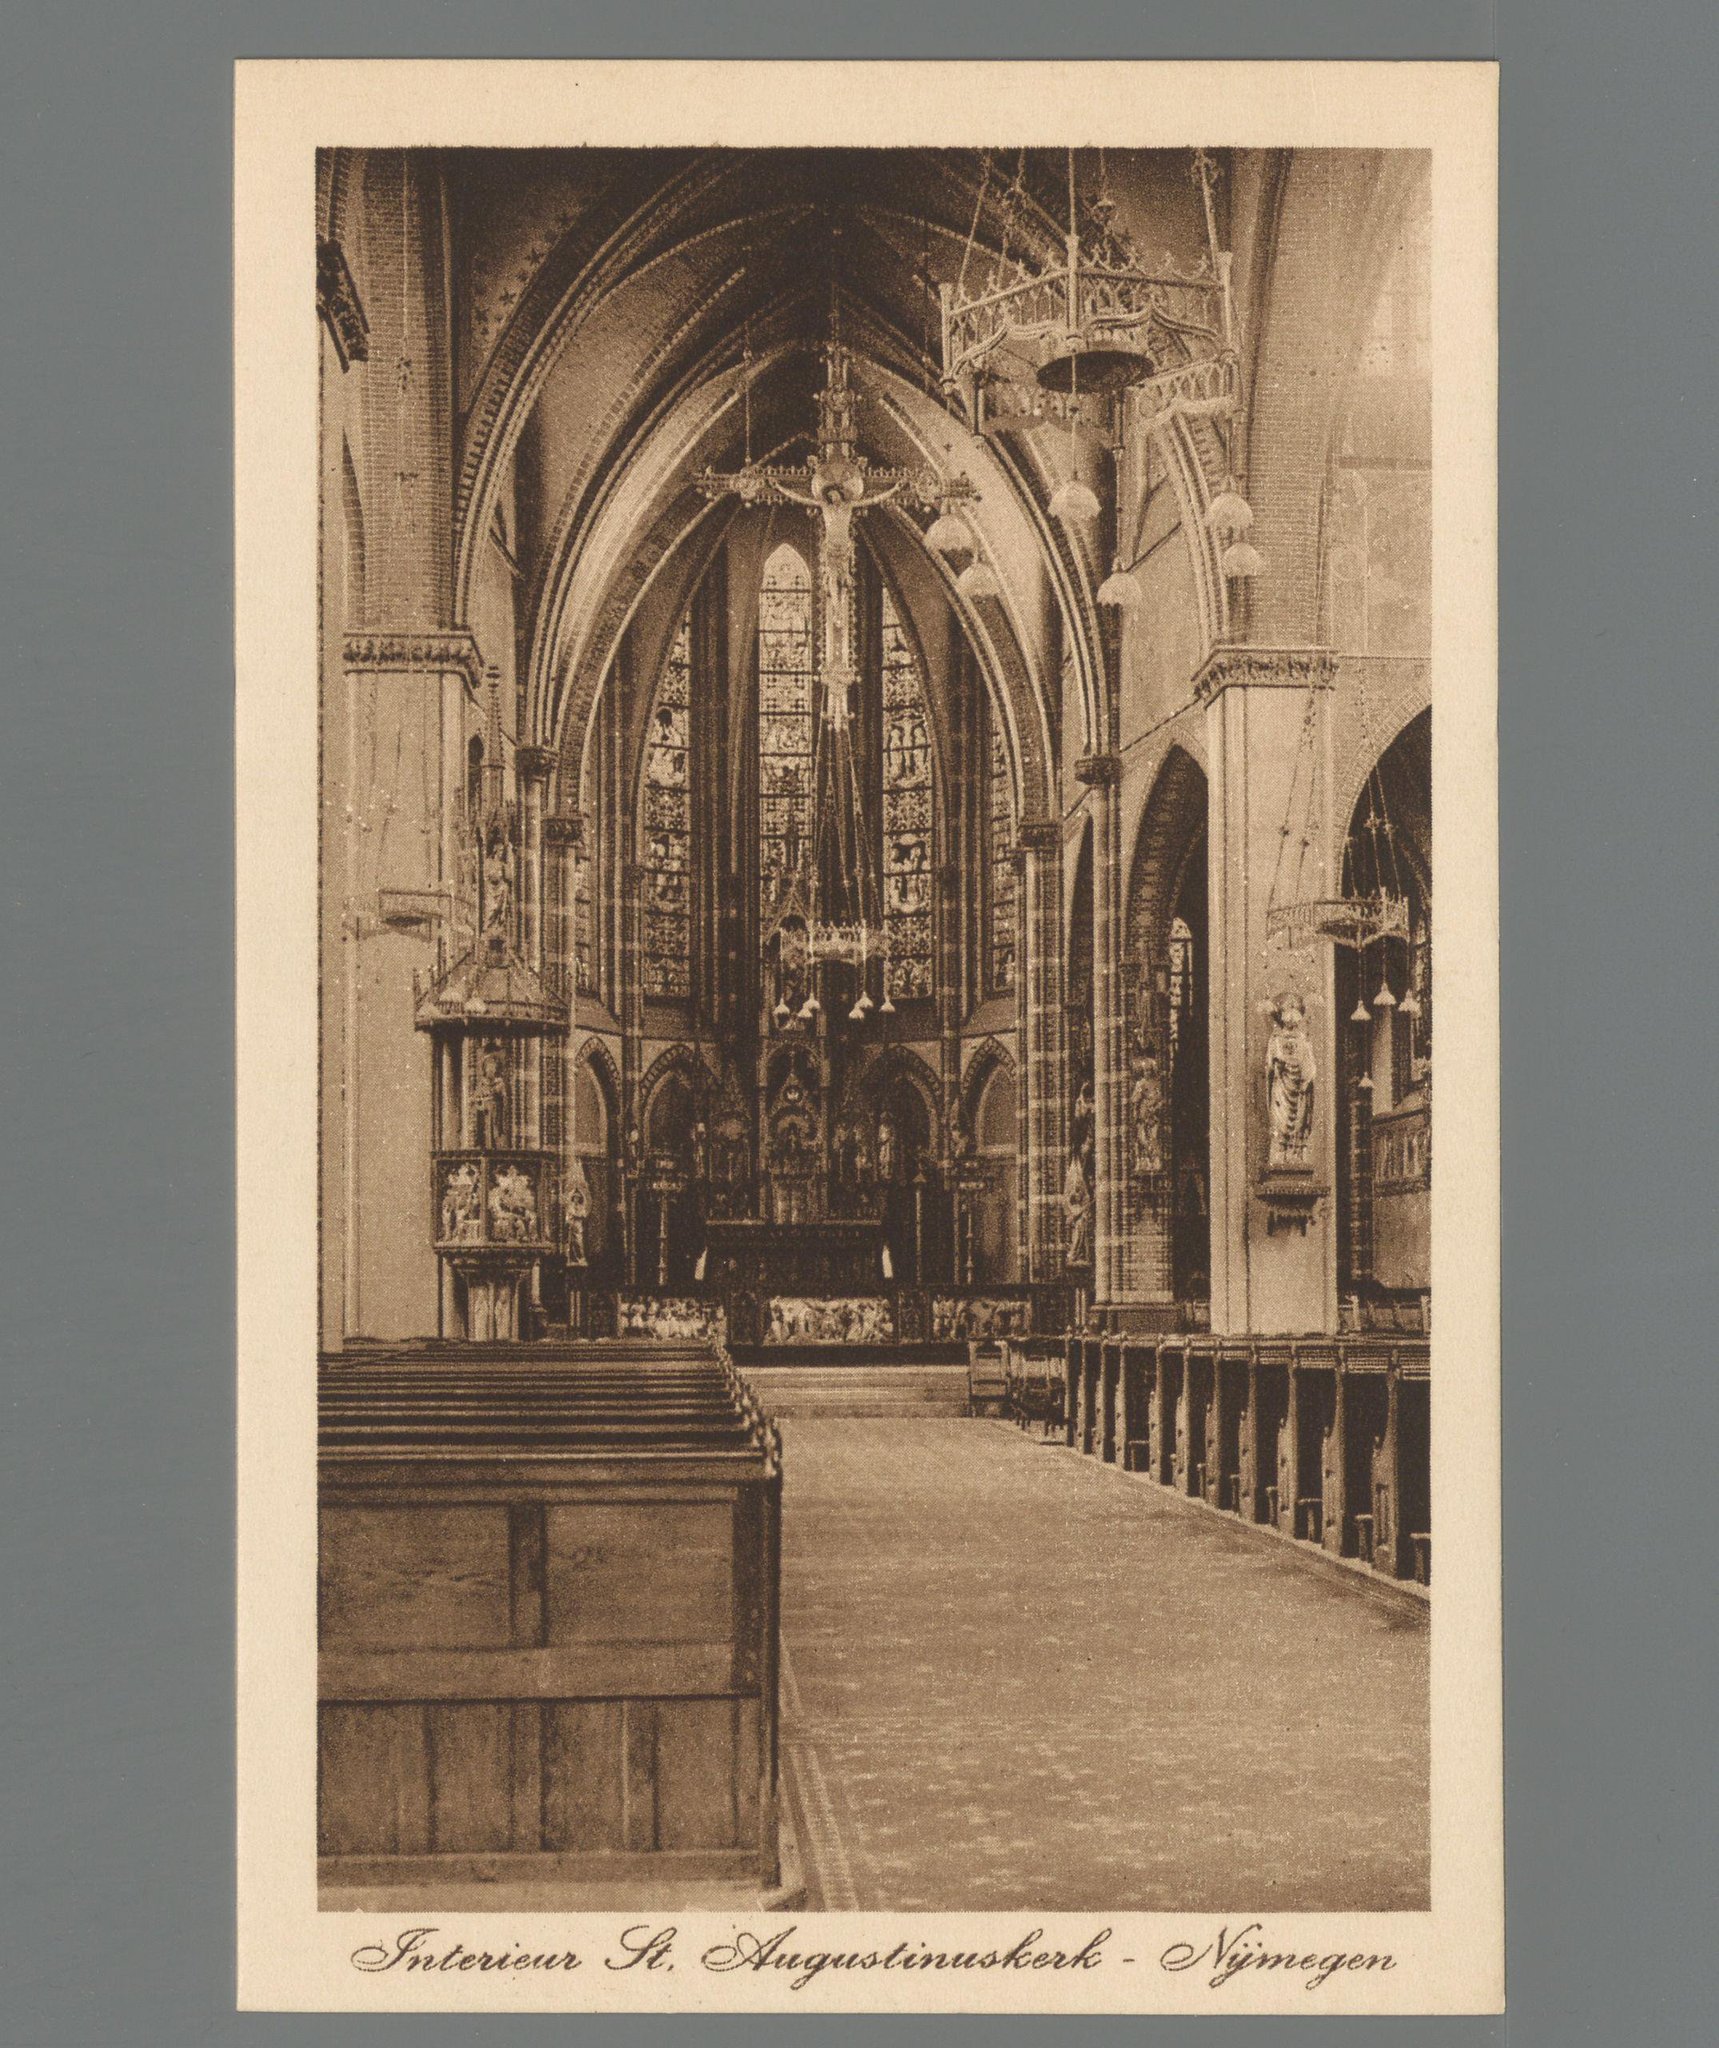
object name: ansichtkaart, prentbriefkaart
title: Interieur St. Augustinuskerk - Nijmegen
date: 1919-1930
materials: cardboard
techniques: rotogravure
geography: nijmegen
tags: interior of church